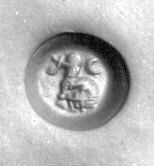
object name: stamp seal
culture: sasanian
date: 401-500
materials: onyx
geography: iran or mesopotamia